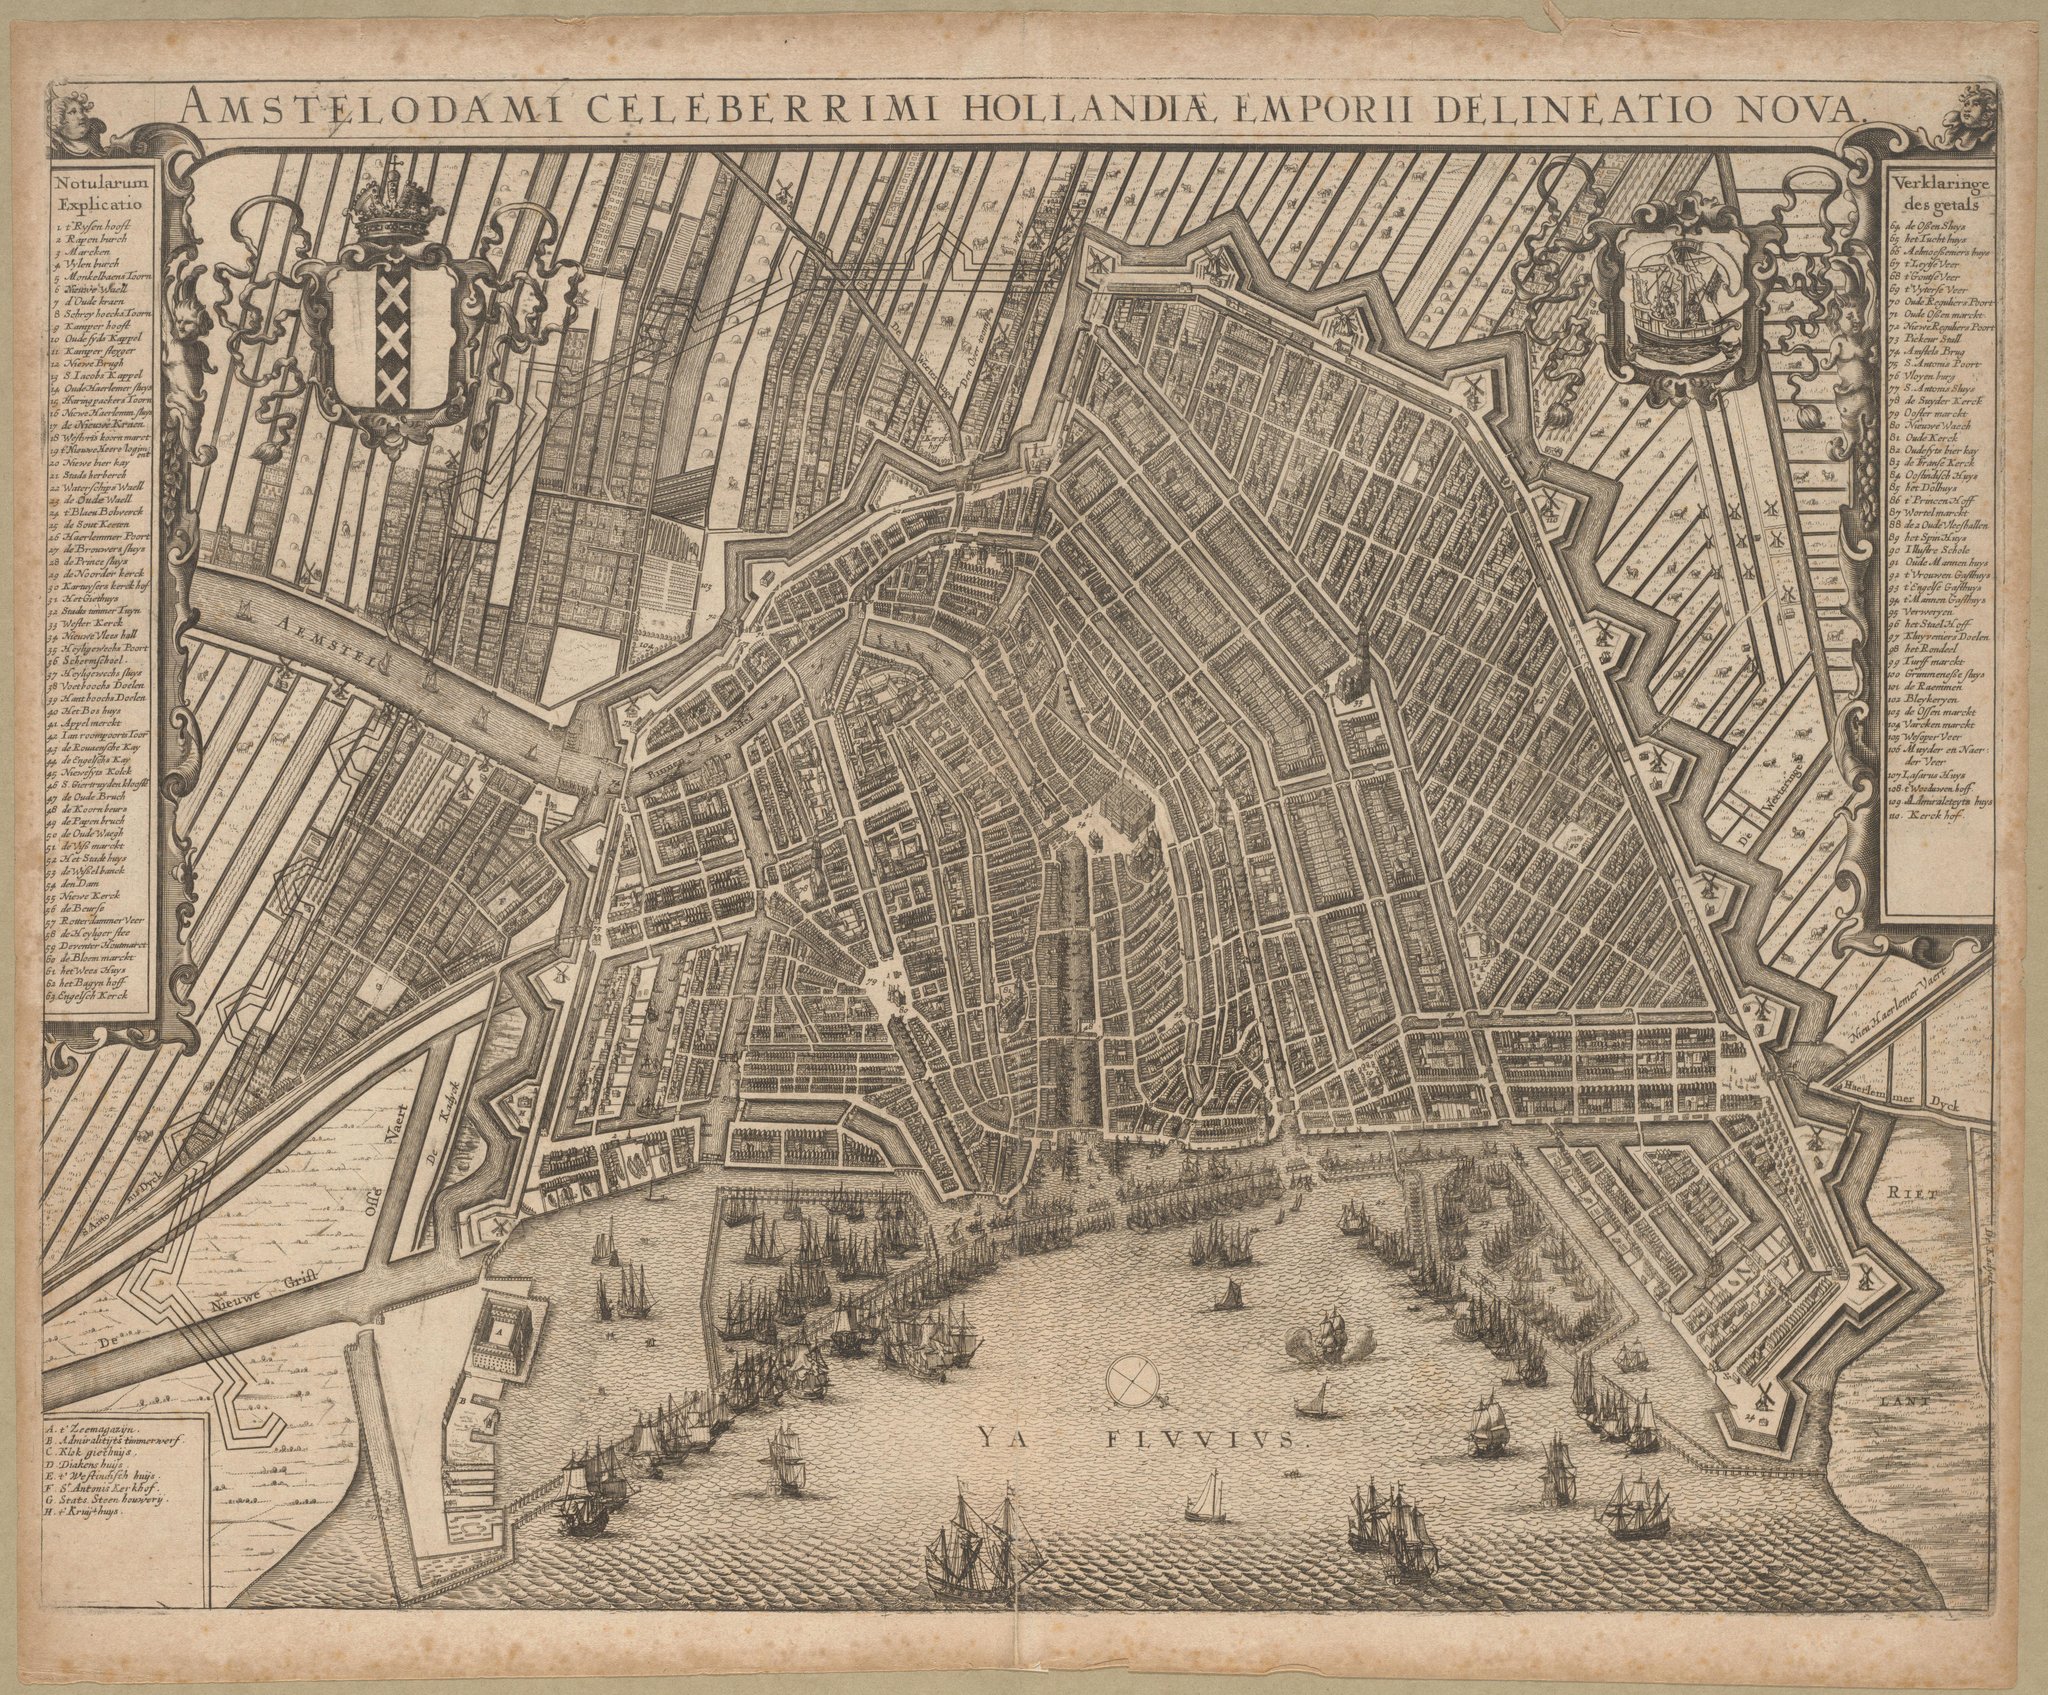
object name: area plan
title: Plattegrond van Amsterdam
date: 1657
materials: paper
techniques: engraving, etching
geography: amsterdam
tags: coat of arms (as symbol of the state, etc.) (+ city; municipal), maps of cities, amsterdam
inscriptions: collector's mark: Lugt 1641b